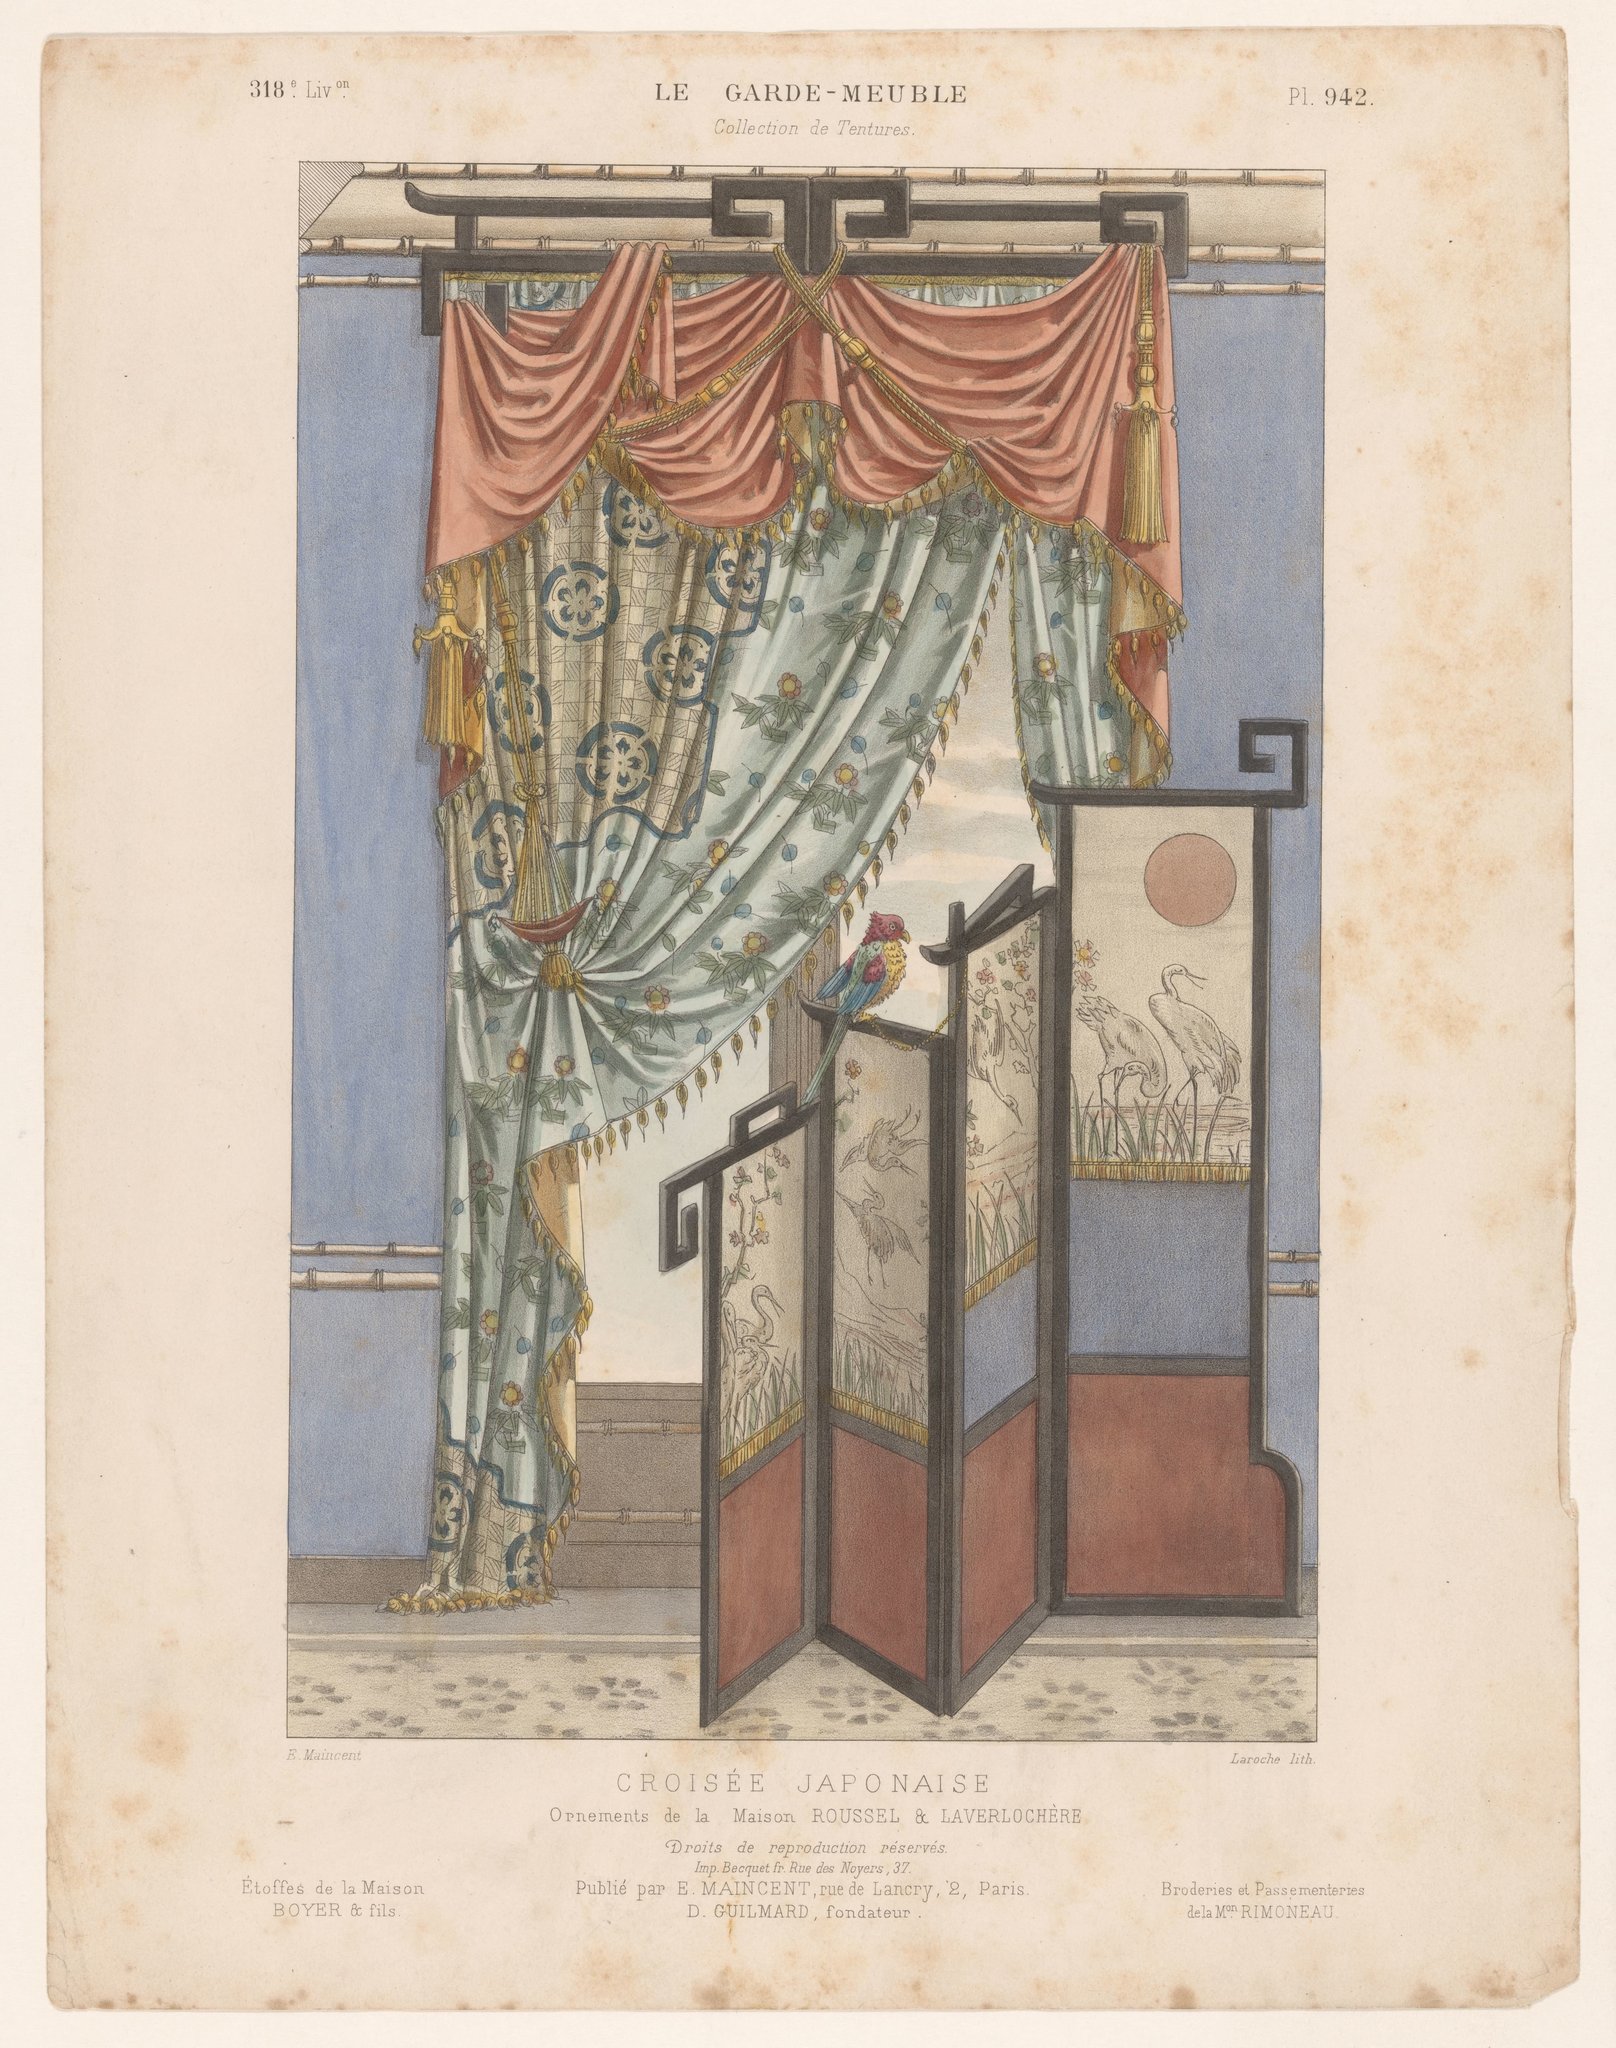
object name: print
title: Le Garde-Meuble / Collection de Tentures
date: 1885-1895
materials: paper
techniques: hand coloring, lithograph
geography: paris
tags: window, screen, folding screen, hangings and drapery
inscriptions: : ‘Droits de reproduction réservés.’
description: Kruisvenster met kamerscherm, papegaai en gedrapeerde gordijnen in Japanse stijl. Prent uit 318e Livraison.